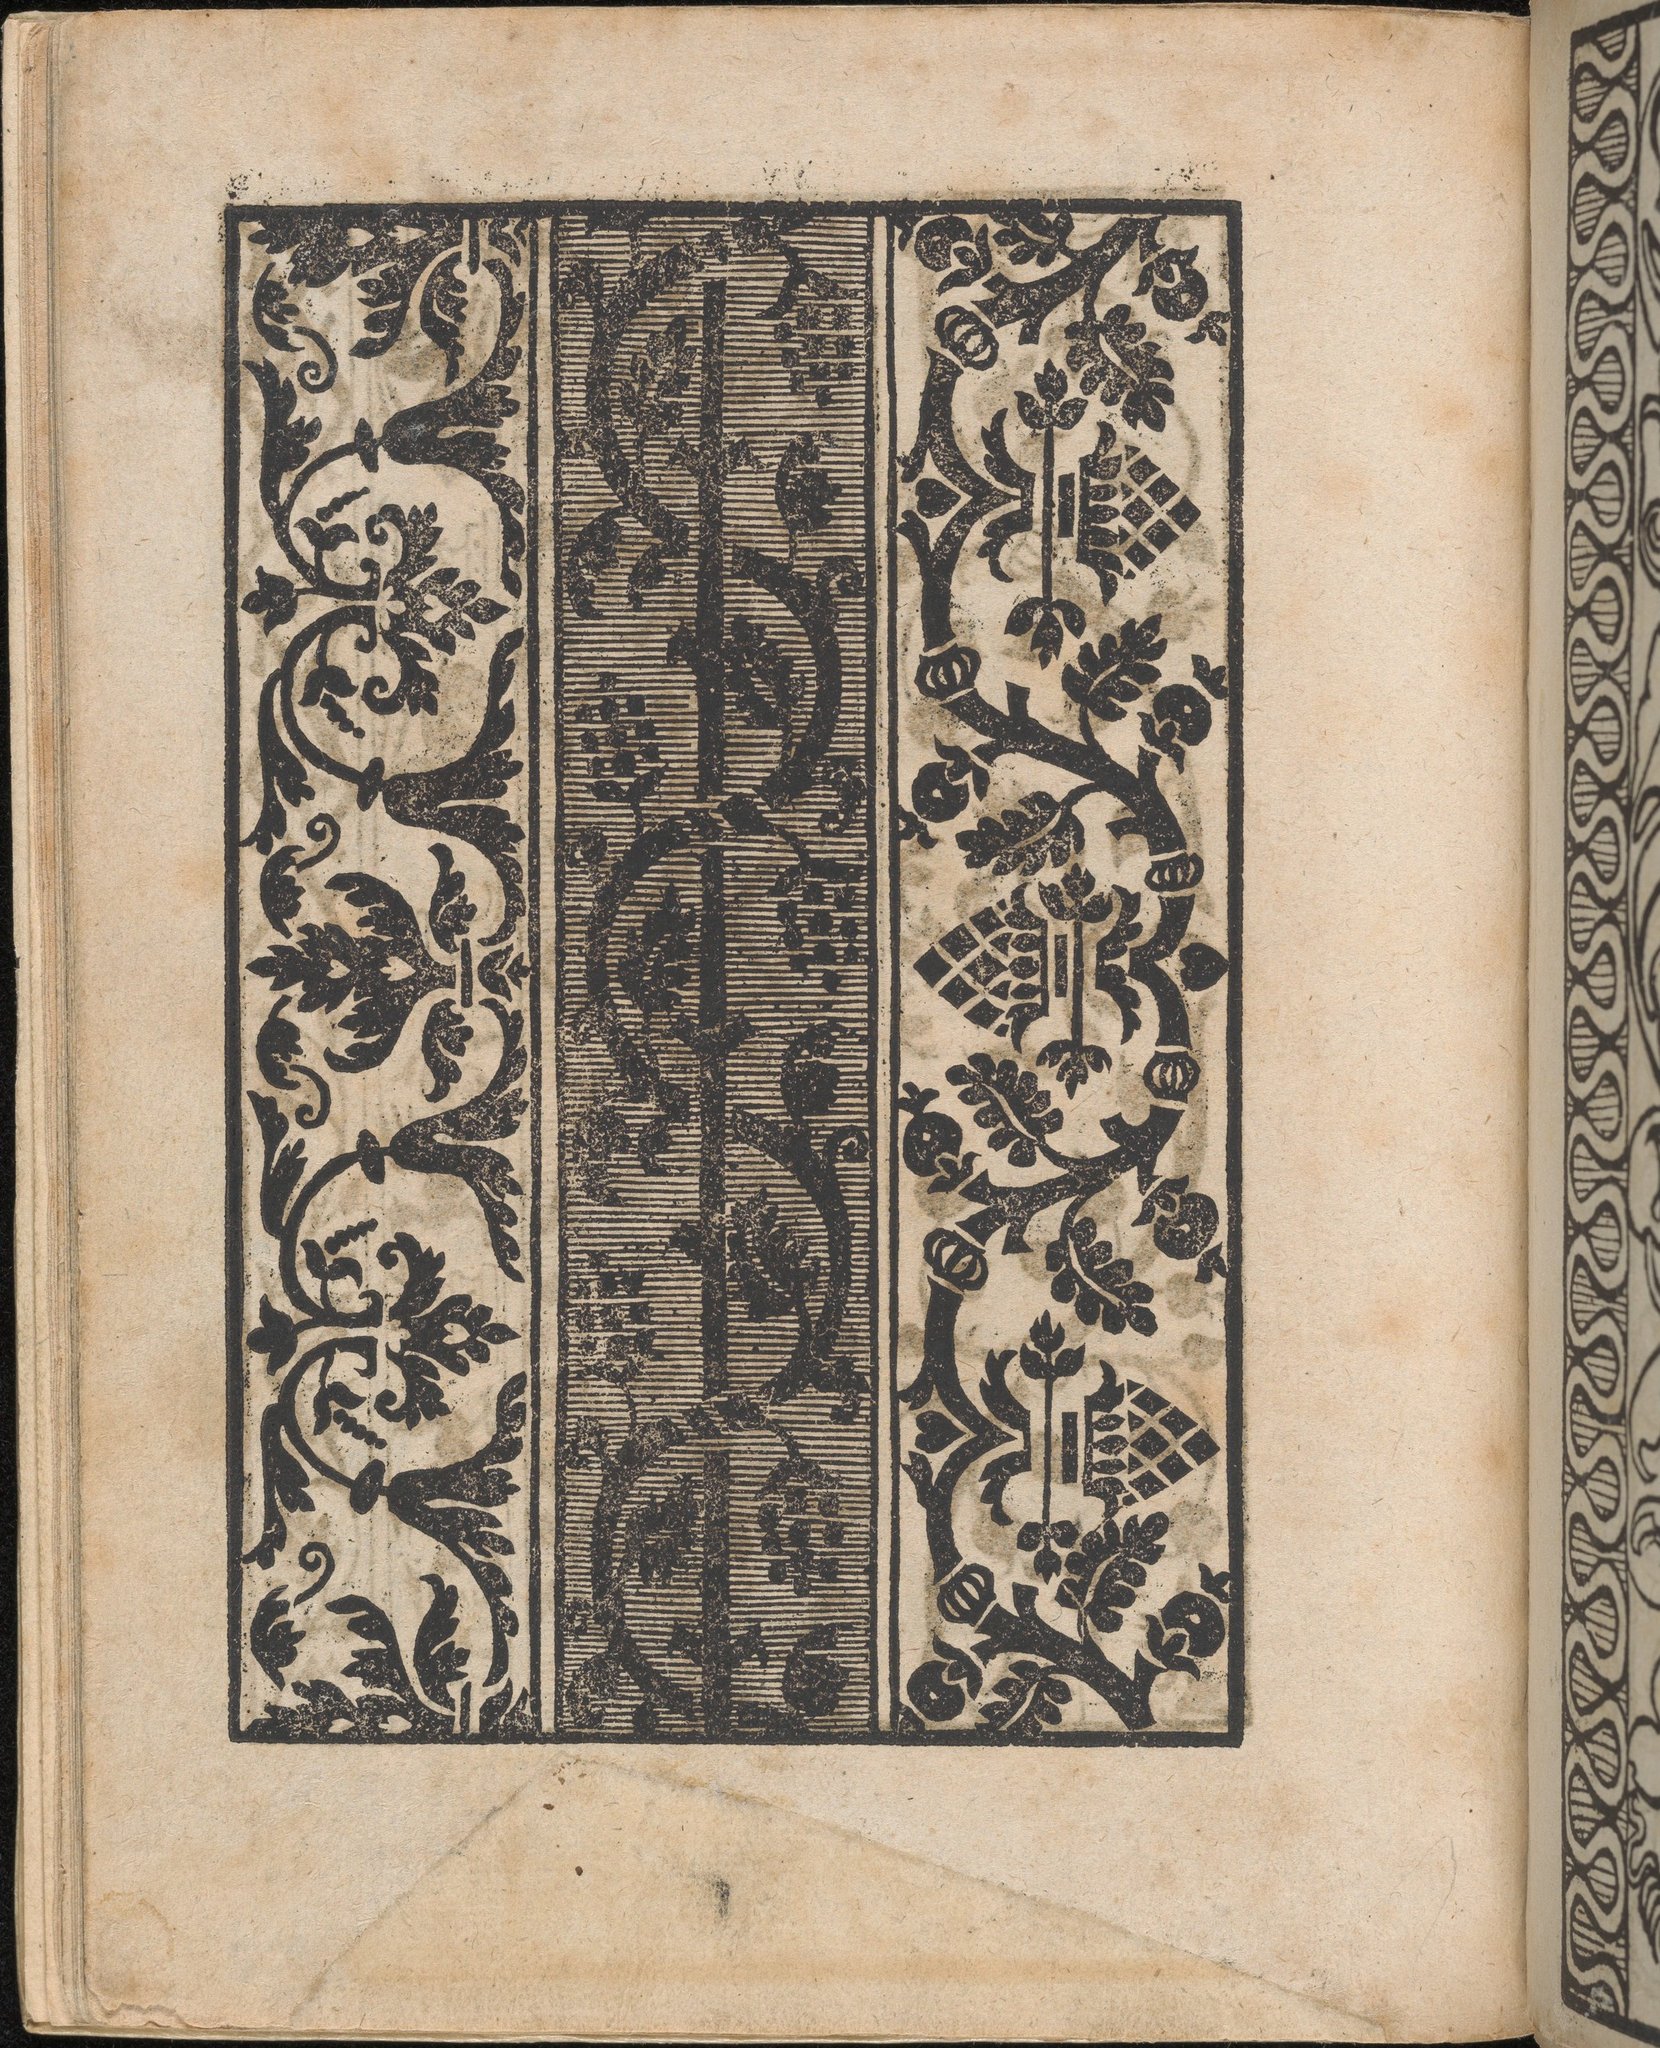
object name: book print ornament architecture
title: Ein new Modelbuch..., page 12 (verso)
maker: johann schönsperger the younger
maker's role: publisher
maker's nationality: german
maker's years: 1490-1550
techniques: woodcut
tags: grapes,flowers,vines